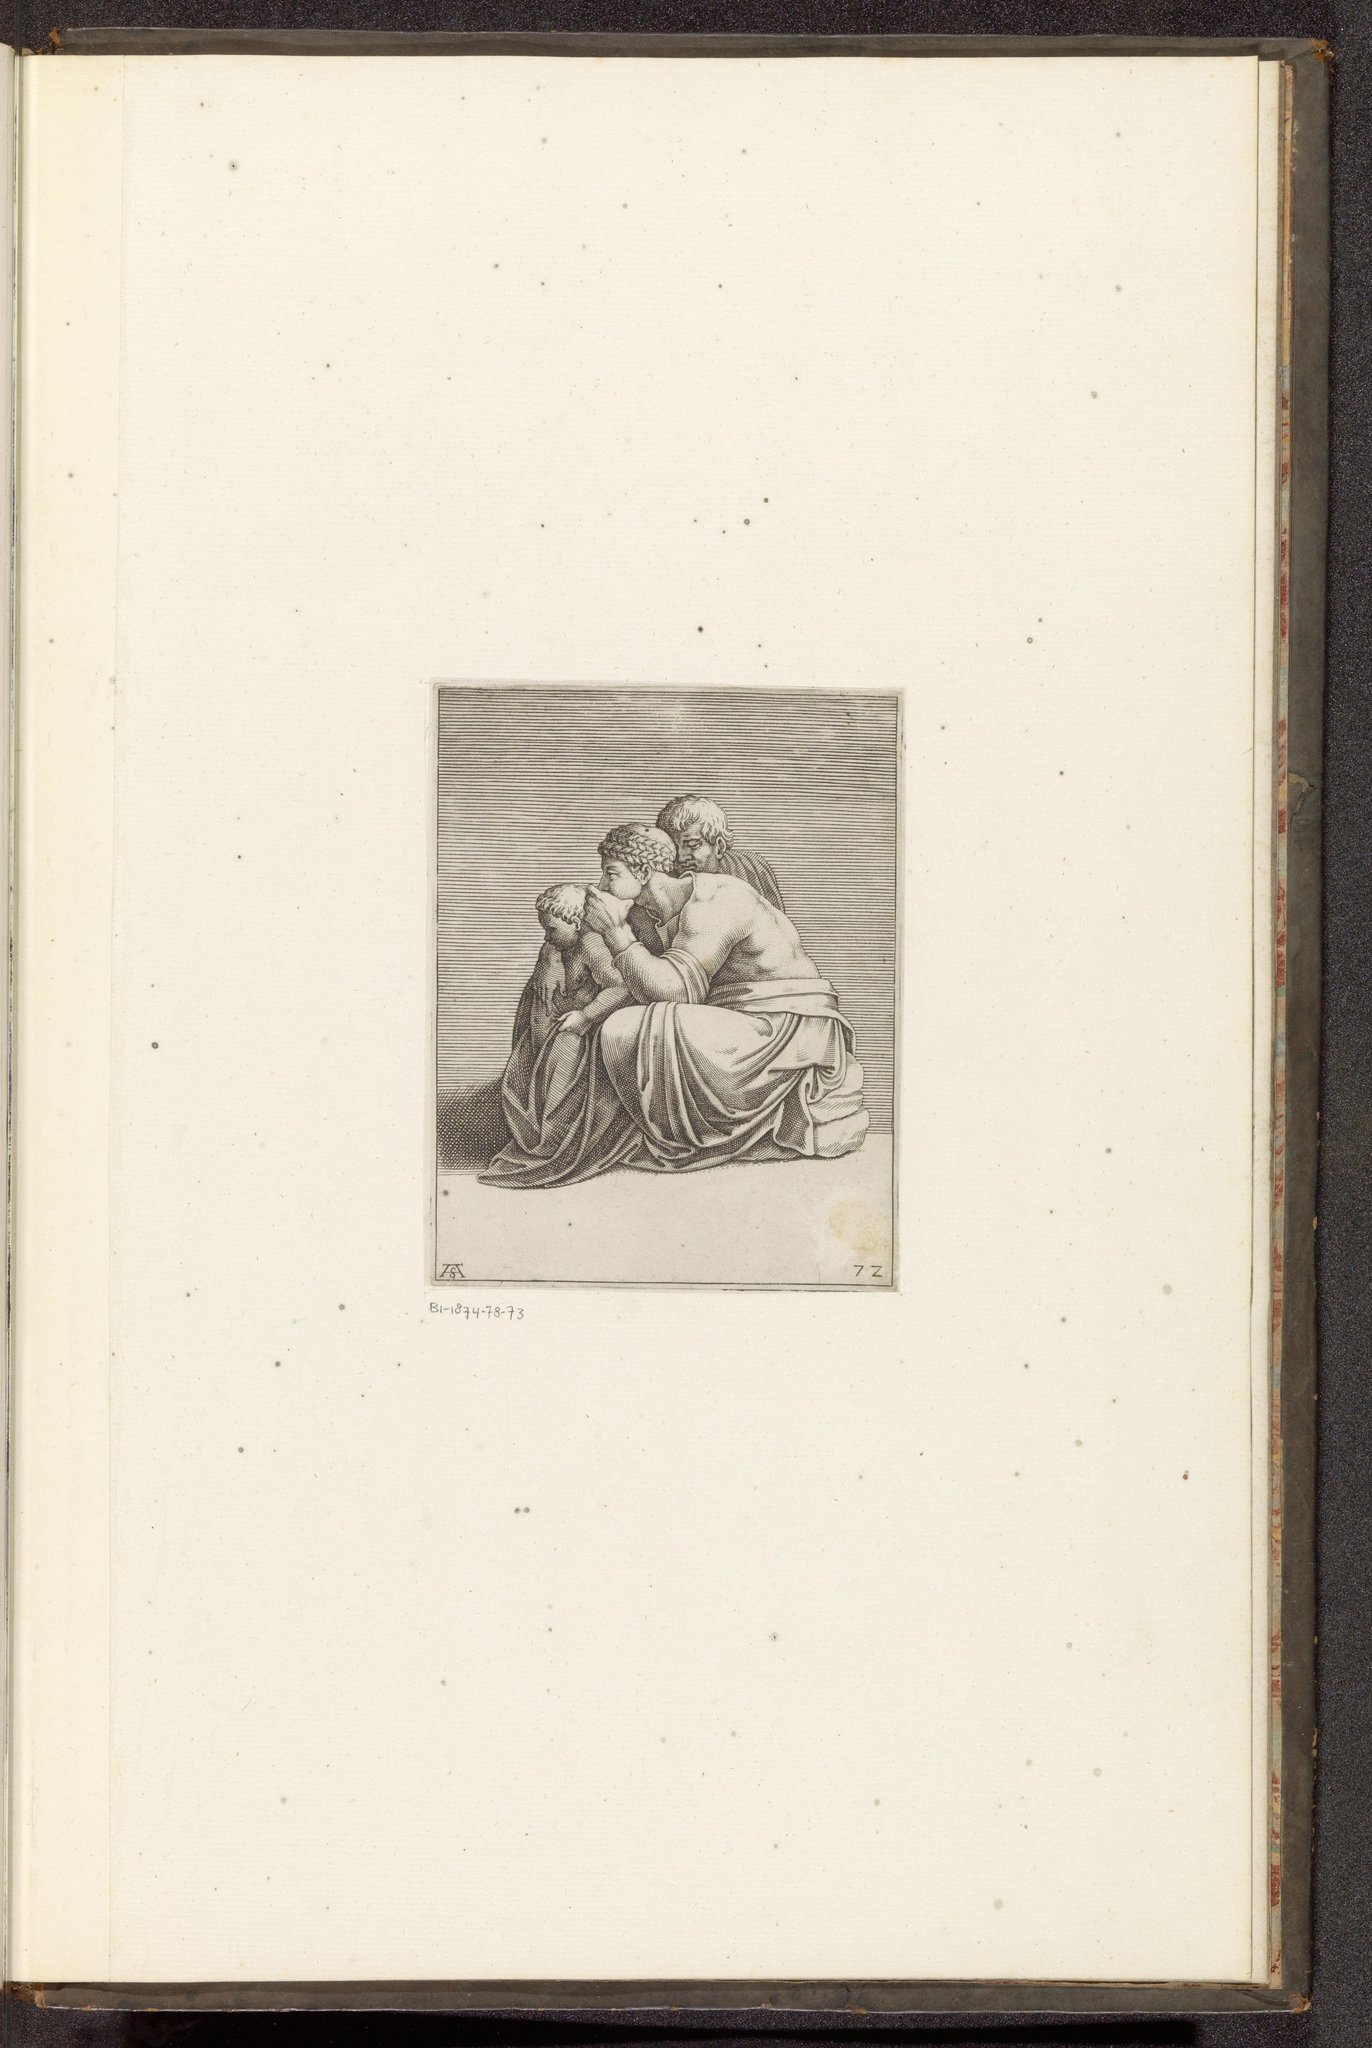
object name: album leaf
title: Schilderingen in de Sixtijnse kapel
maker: adamo scultori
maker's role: painter, print maker, sculptor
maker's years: 1530-1585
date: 1585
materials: paper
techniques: engraving, intaglio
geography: italy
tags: mother and child(ren), woman and child(ren) (family group), father and child(ren), man and child(ren) (family group)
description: Deze prent maakt deel uit van een serie bestaande uit een titelprent en 72 prenten naar schilderingen door Michelangelo in de Sixtijnse Kapel in het Vaticaan.